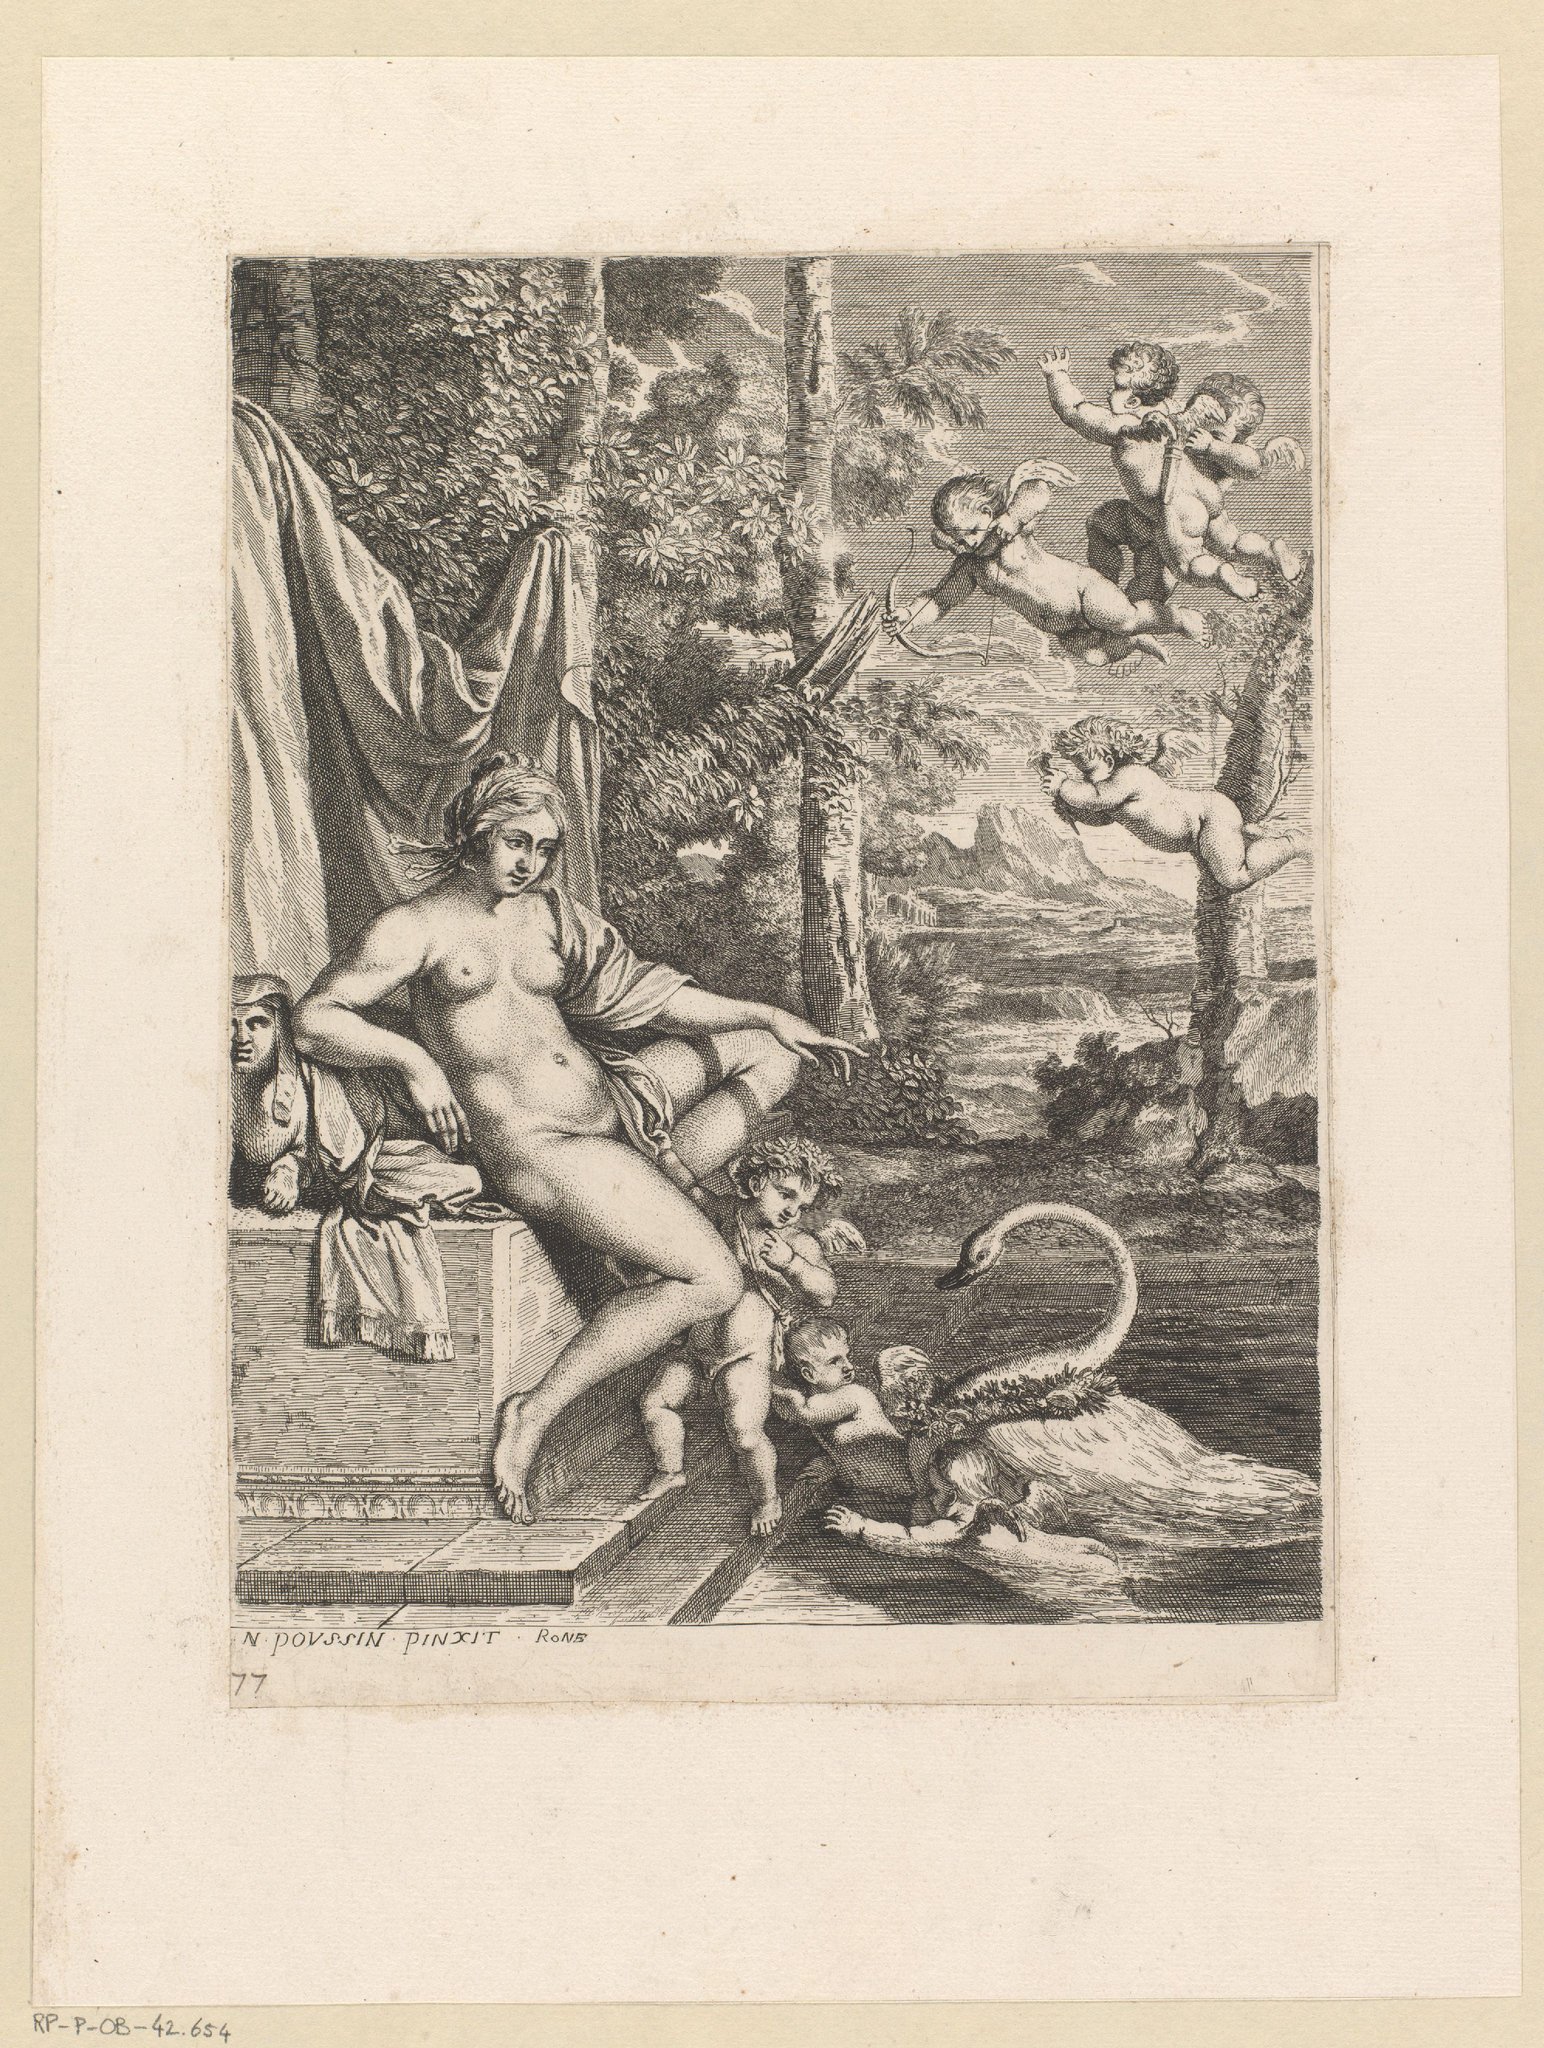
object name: print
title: Leda en de zwaan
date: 1649-1734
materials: paper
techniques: etching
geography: france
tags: jupiter, in the shape of a swan, and leda, water-birds: swan, cupids: 'amores', 'amoretti', 'putti'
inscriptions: number: ‘77’, collector's mark: Lugt 240